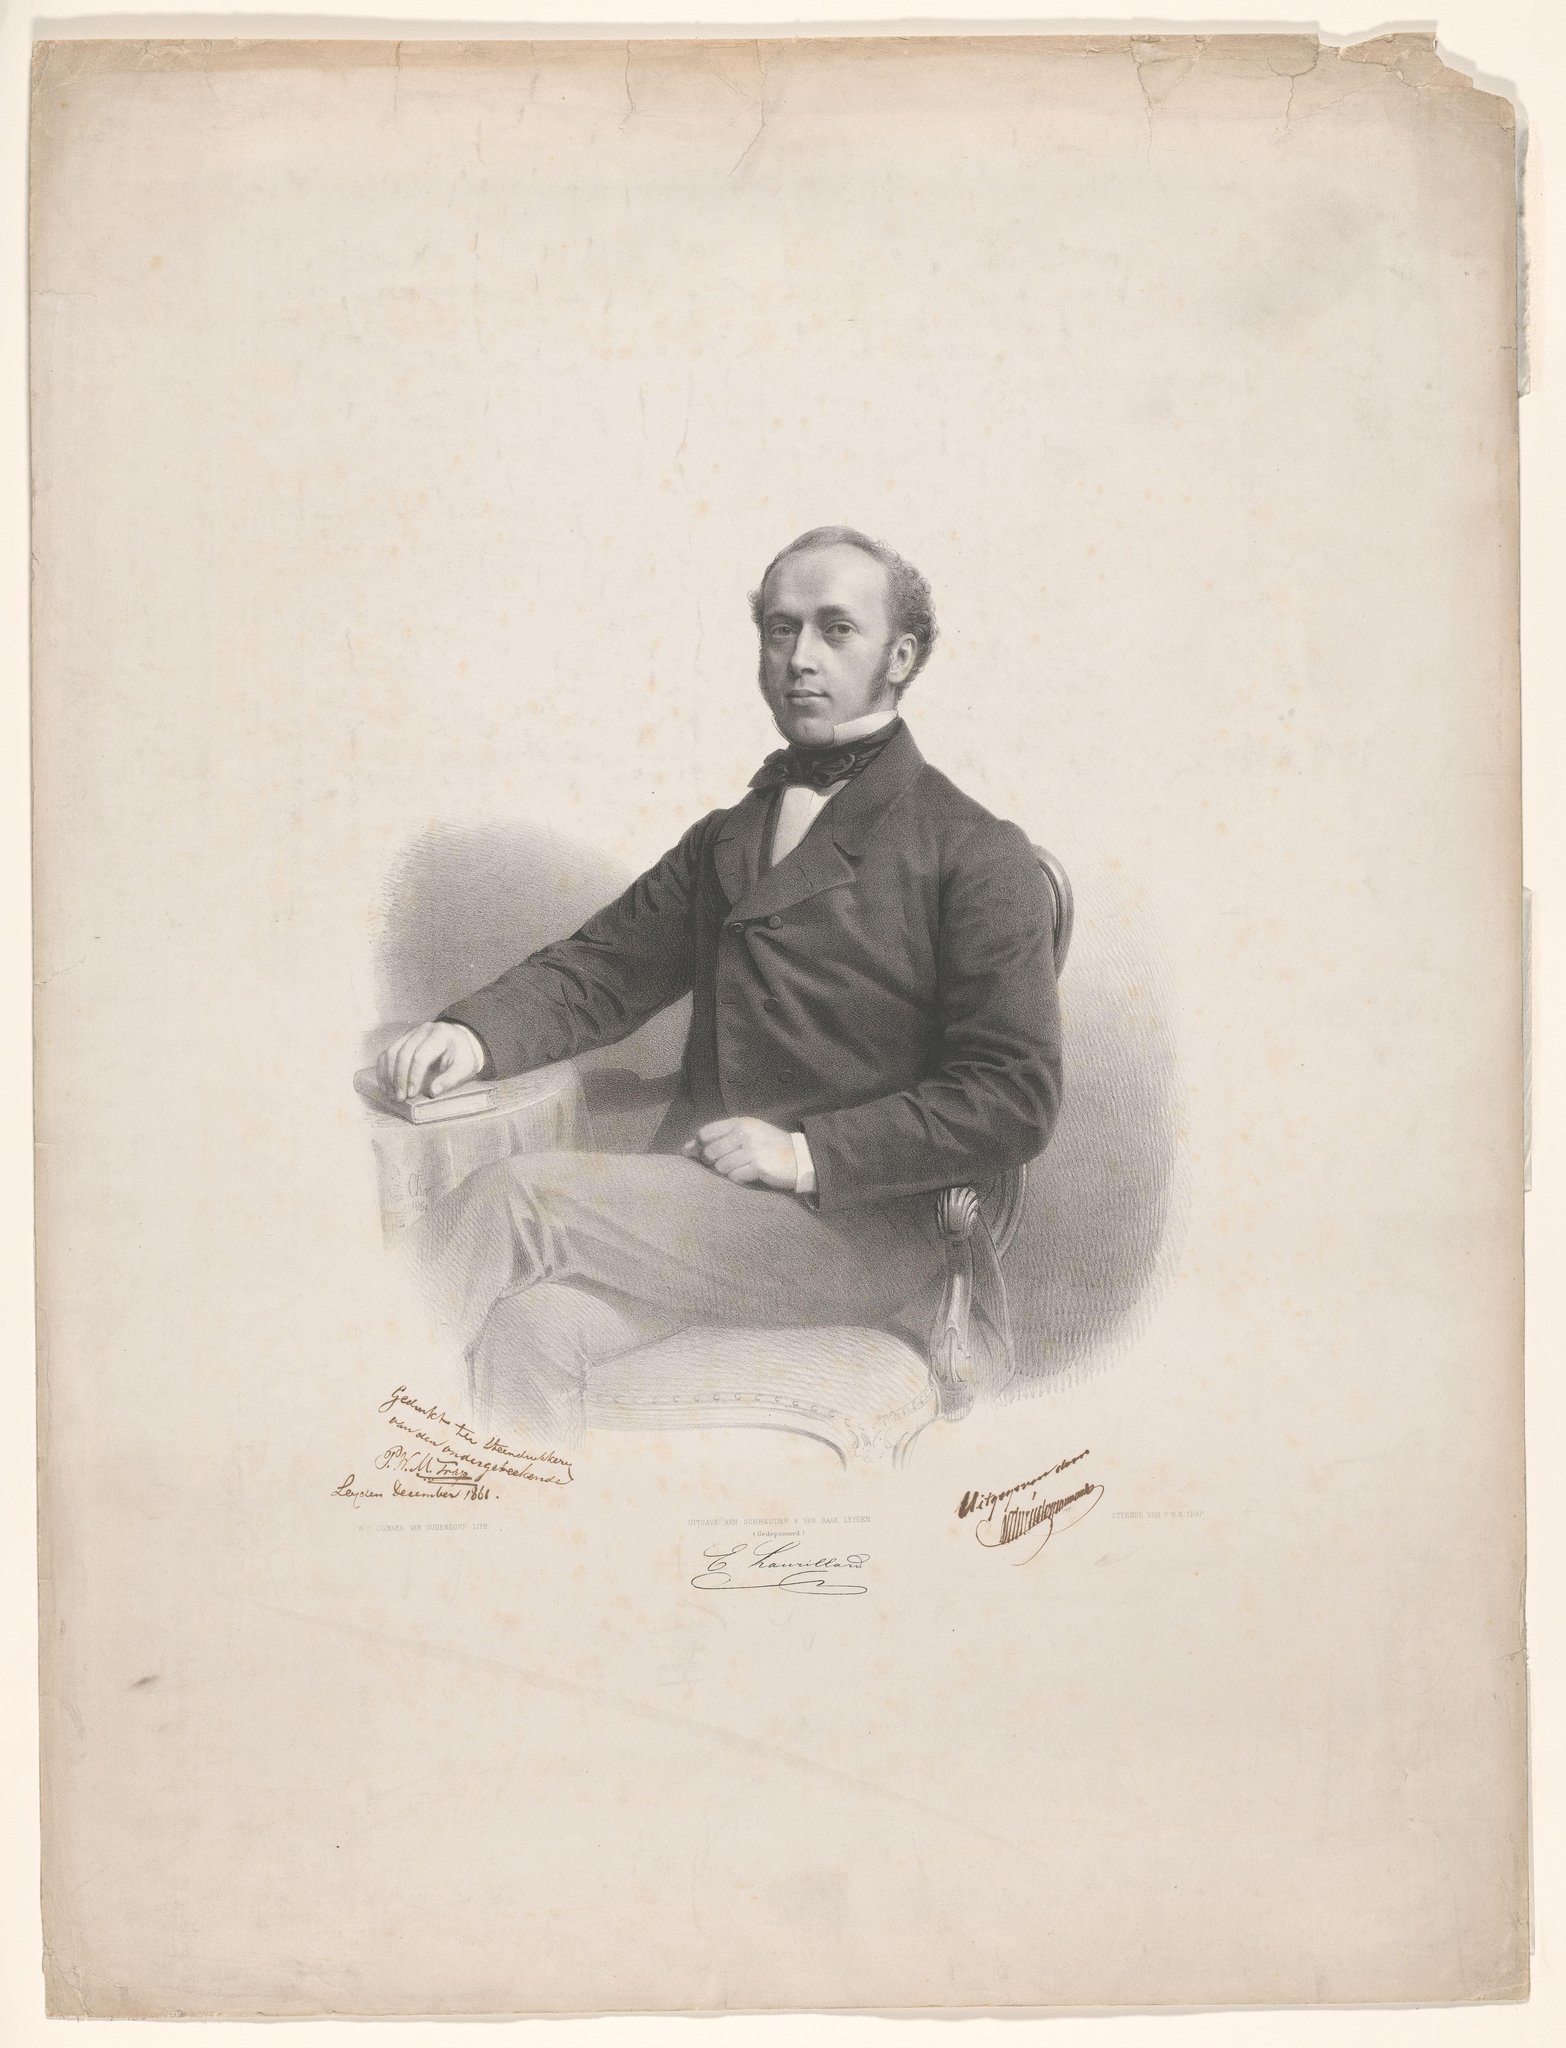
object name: print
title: Portret van Eliza Laurillard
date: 1861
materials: paper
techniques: lithograph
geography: leiden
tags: rotterdam, eliza laurillard, historical persons (+ (full) bust portrait)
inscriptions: : ‘Uitgegeven door / (...)’, : ‘Gedeponeerd.’, : ‘Gedrukt ter steendrukkerij / van den ondergeteekende / P.W.M. Trap / Leyden December 1861’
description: Onder het portret de signatuur van de geportretteerde.